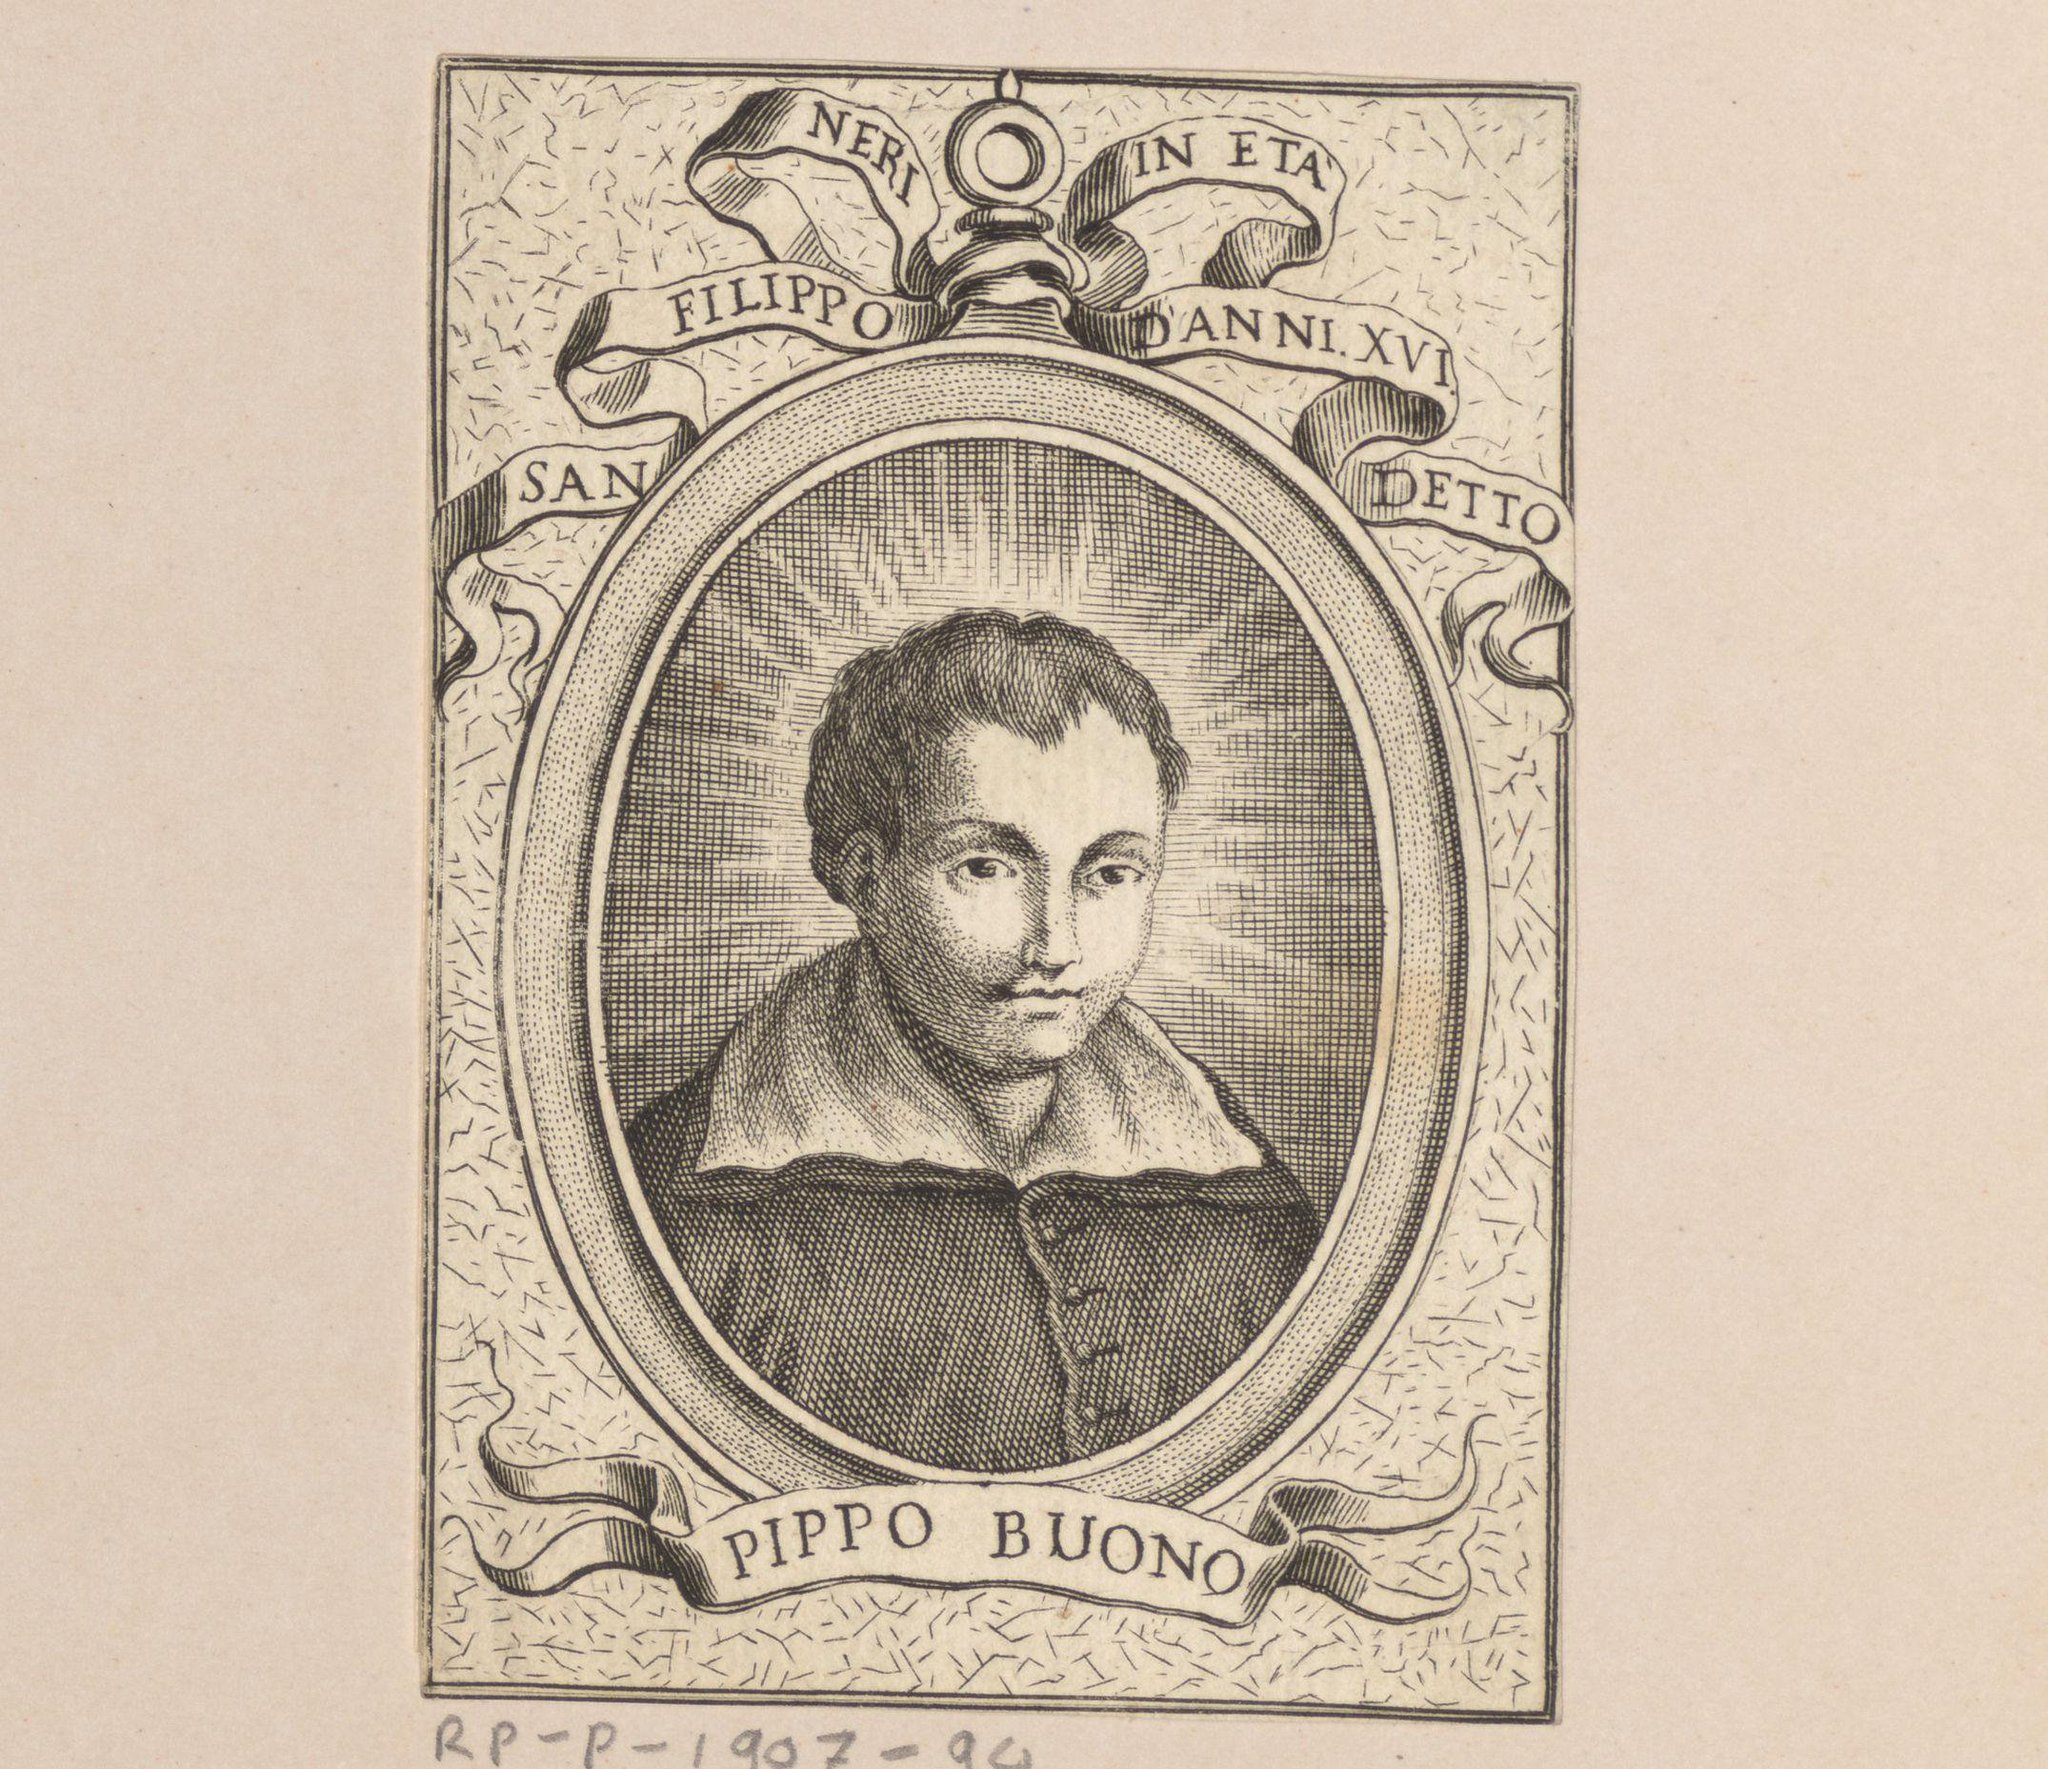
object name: print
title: Portret van Filippo Neri op 16-jarige leeftijd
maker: Anonymous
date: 1650-1749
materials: paper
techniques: engraving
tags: rome, clergyman, priest (roman catholic), historical persons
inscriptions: collector's mark: Lugt 2228